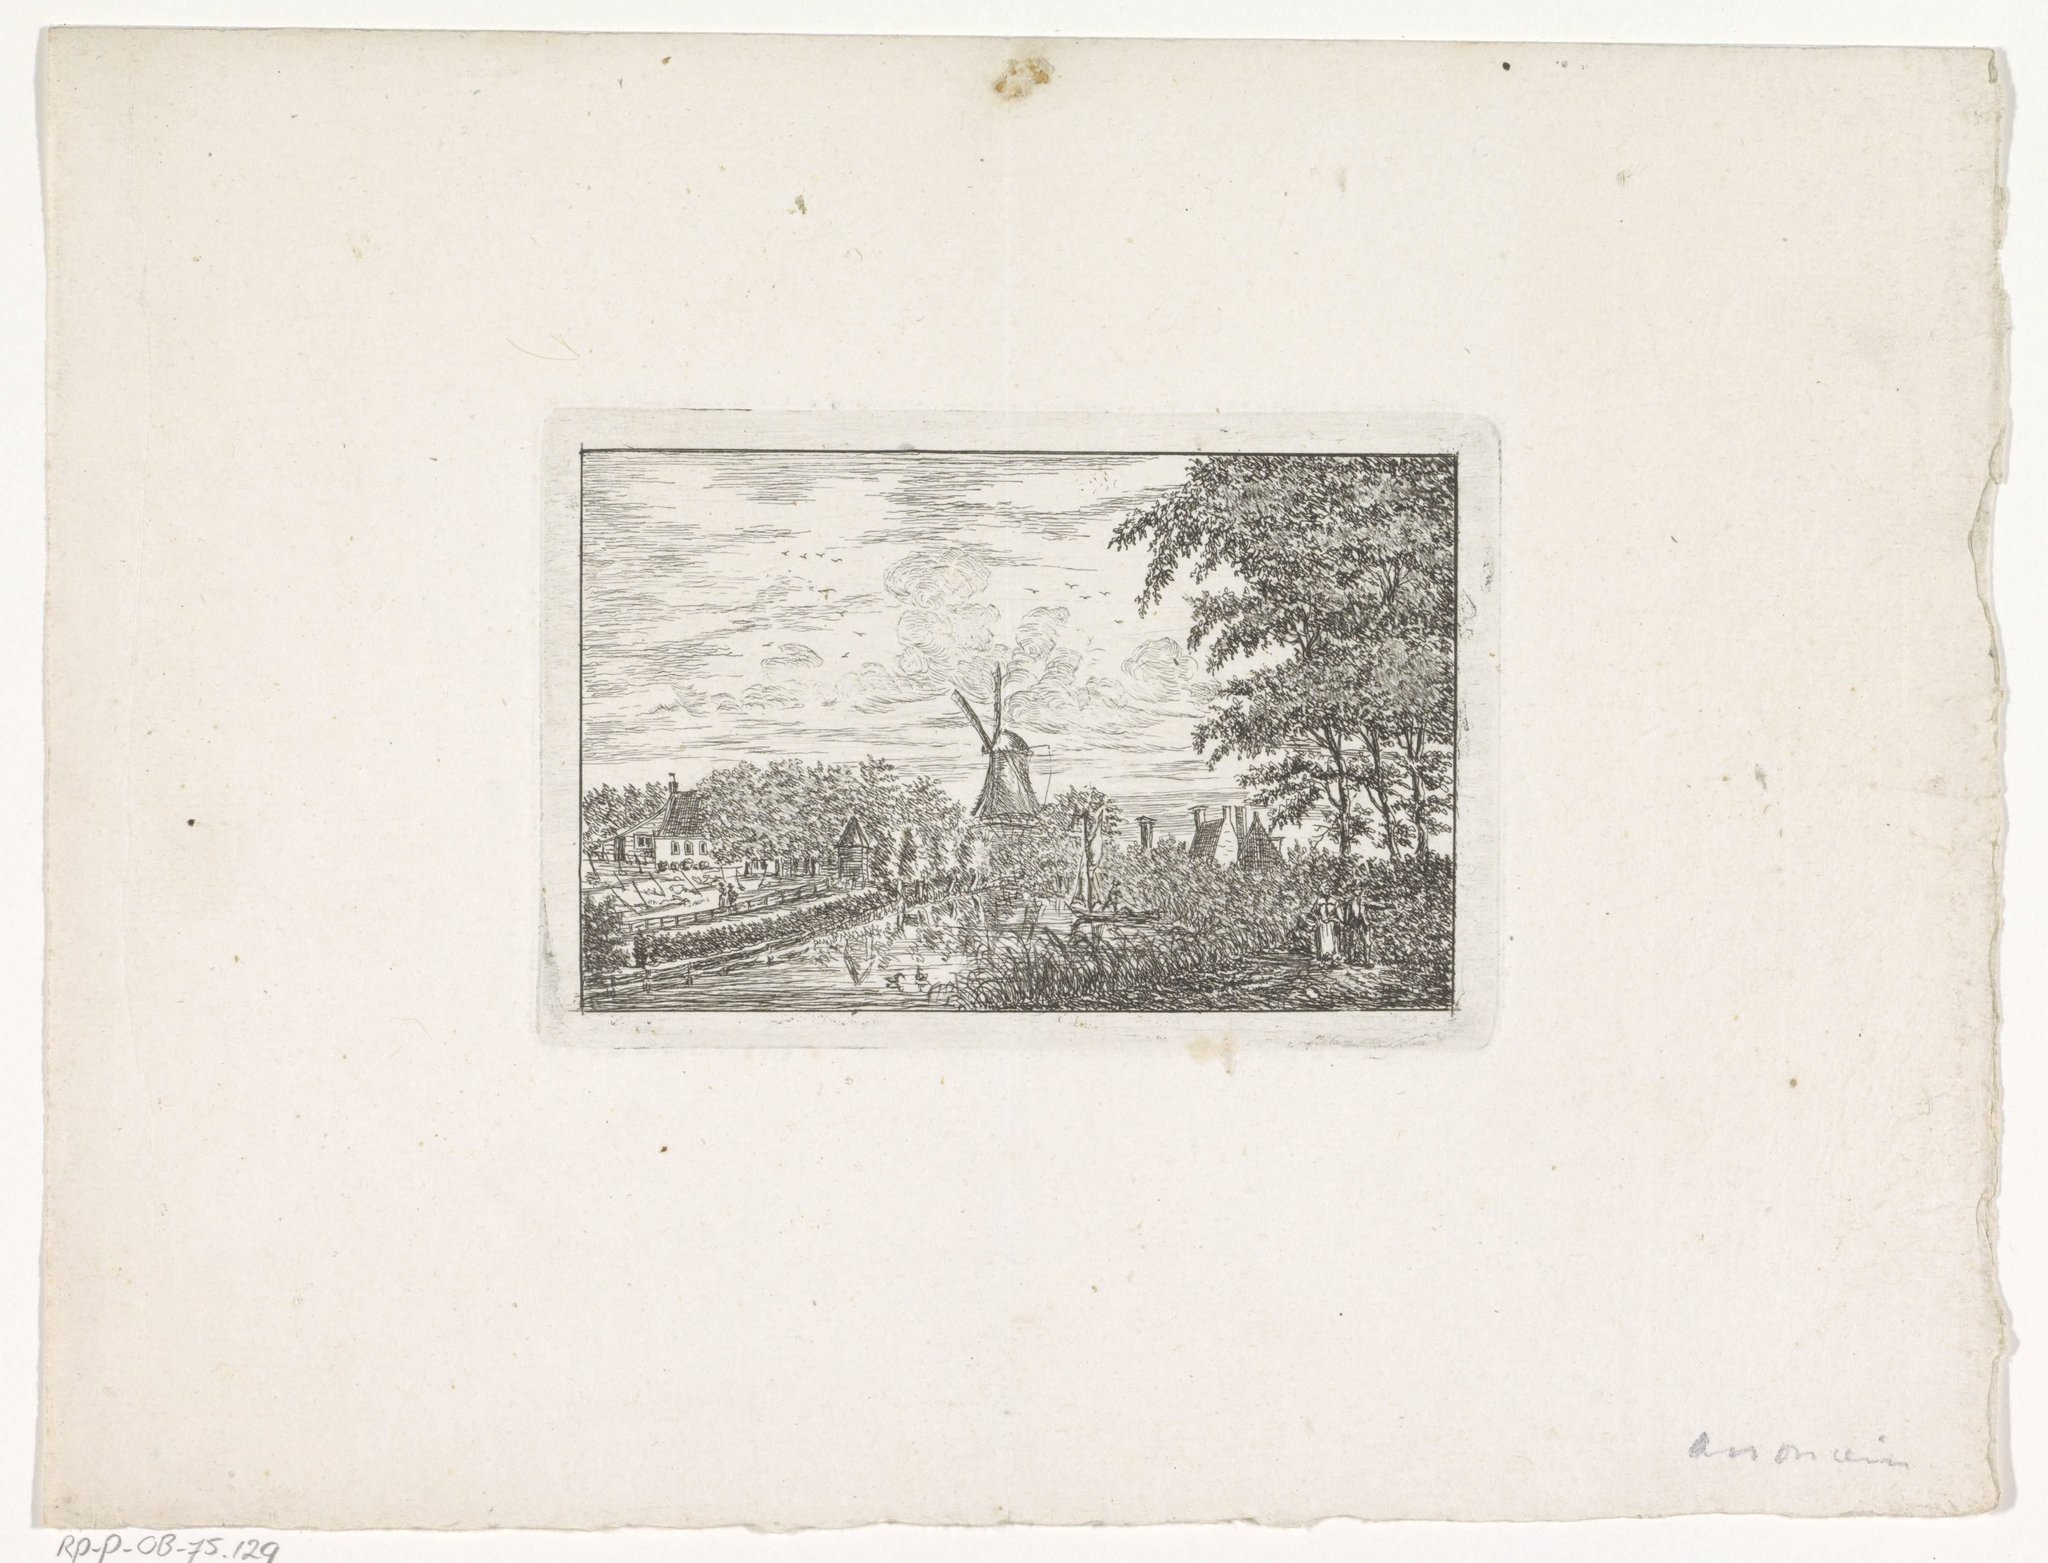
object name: print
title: Landschap met water en een windmolen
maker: Anonymous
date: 1800-1900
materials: paper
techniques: etching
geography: netherlands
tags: windmill in landscape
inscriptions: collector's mark: Lugt 2228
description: Landschap met water op de voorgrond en rechts een wandelend paar. Midden achter een molen.